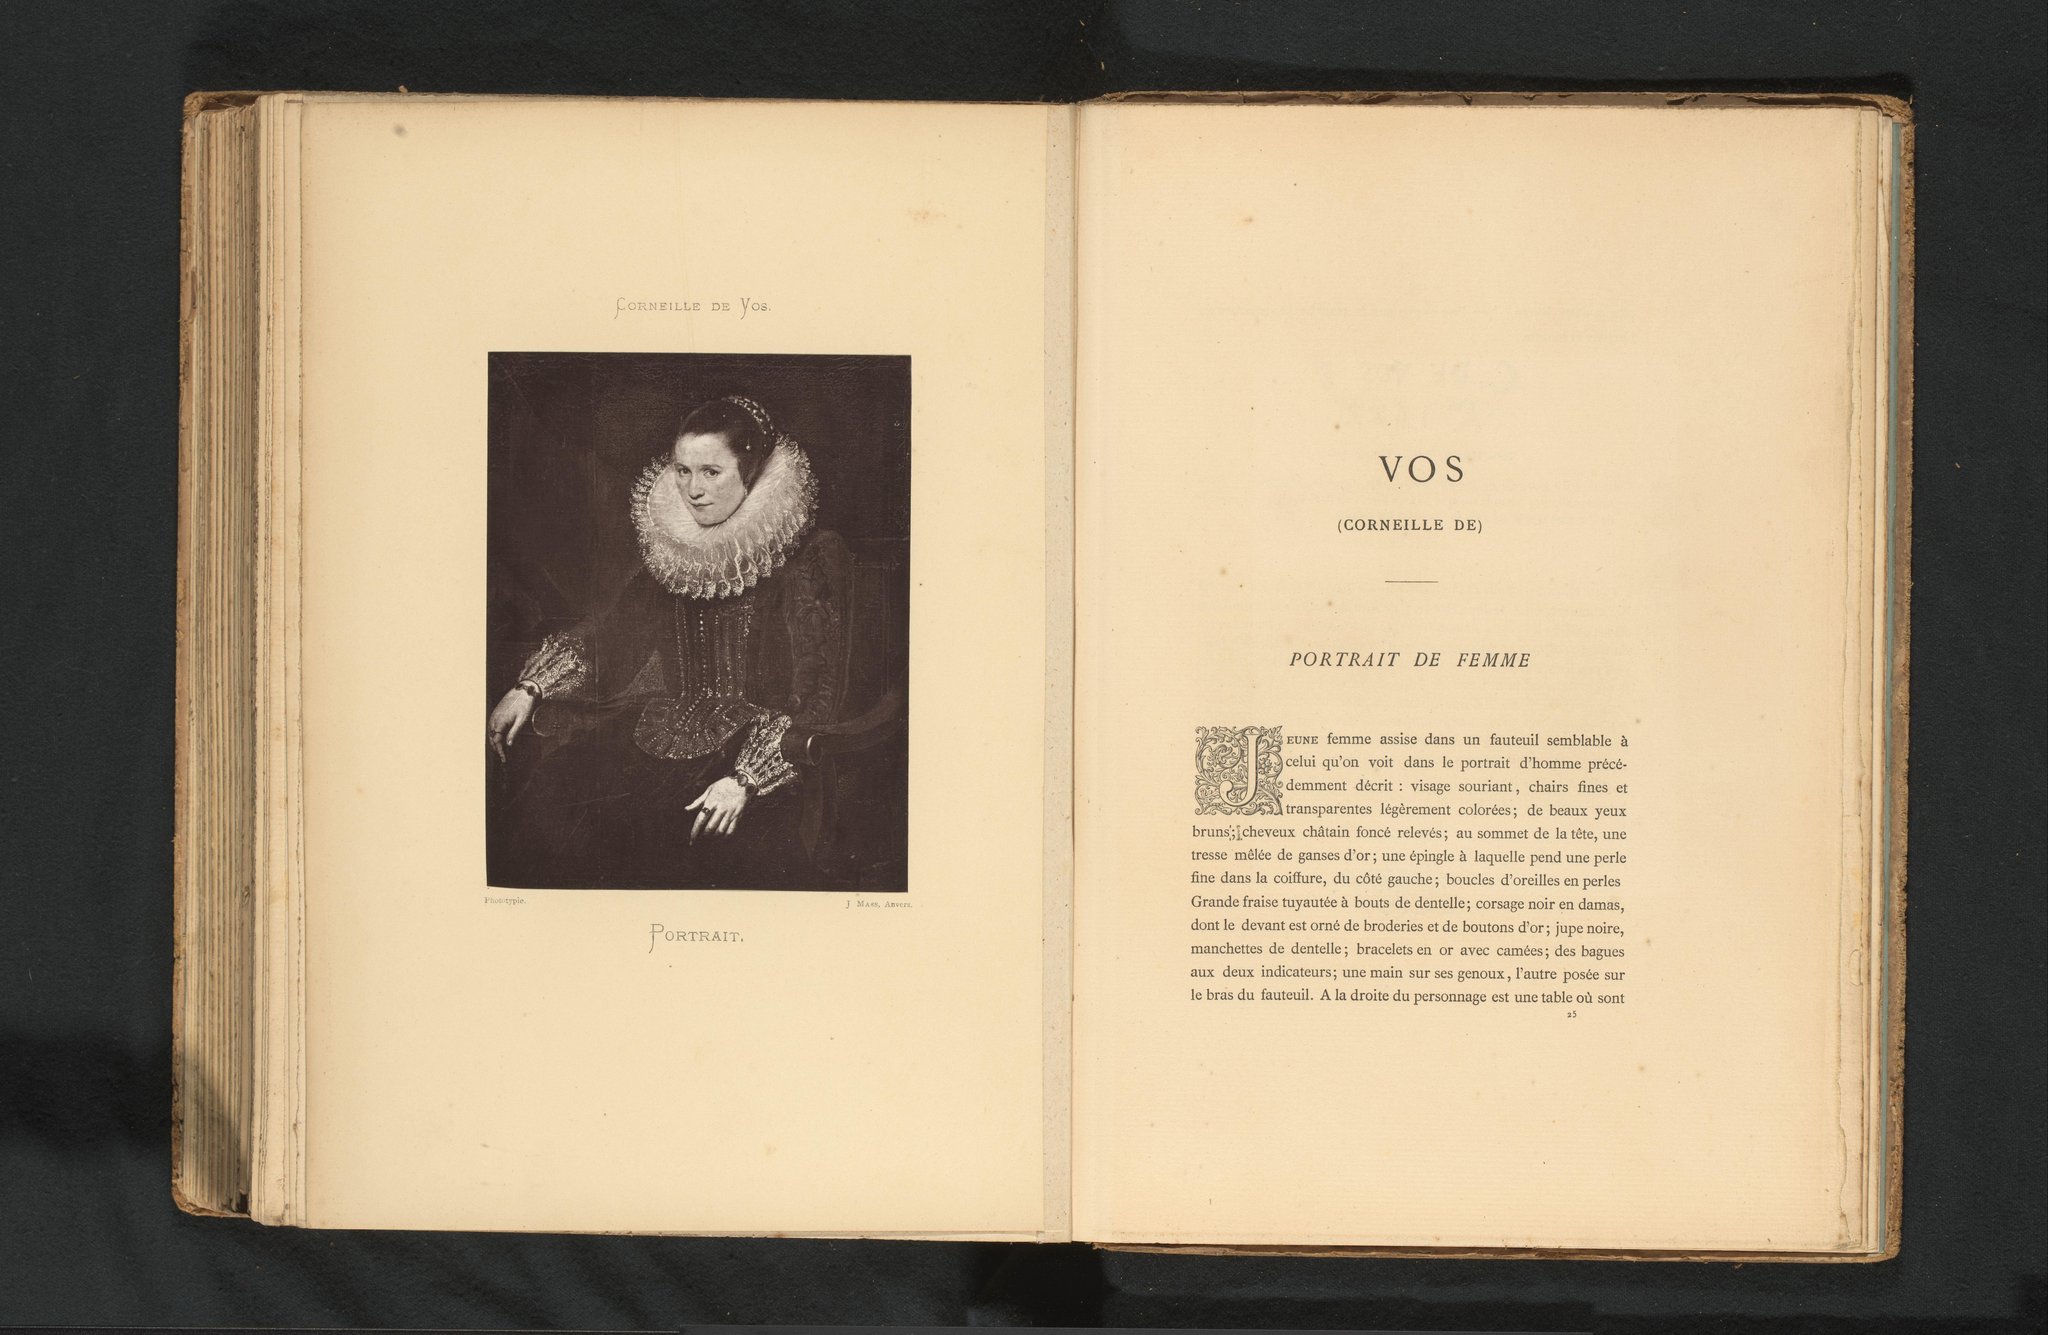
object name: page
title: Portrait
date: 1873-1878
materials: paper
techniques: woodburytype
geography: antwerp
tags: historical persons - bb - woman